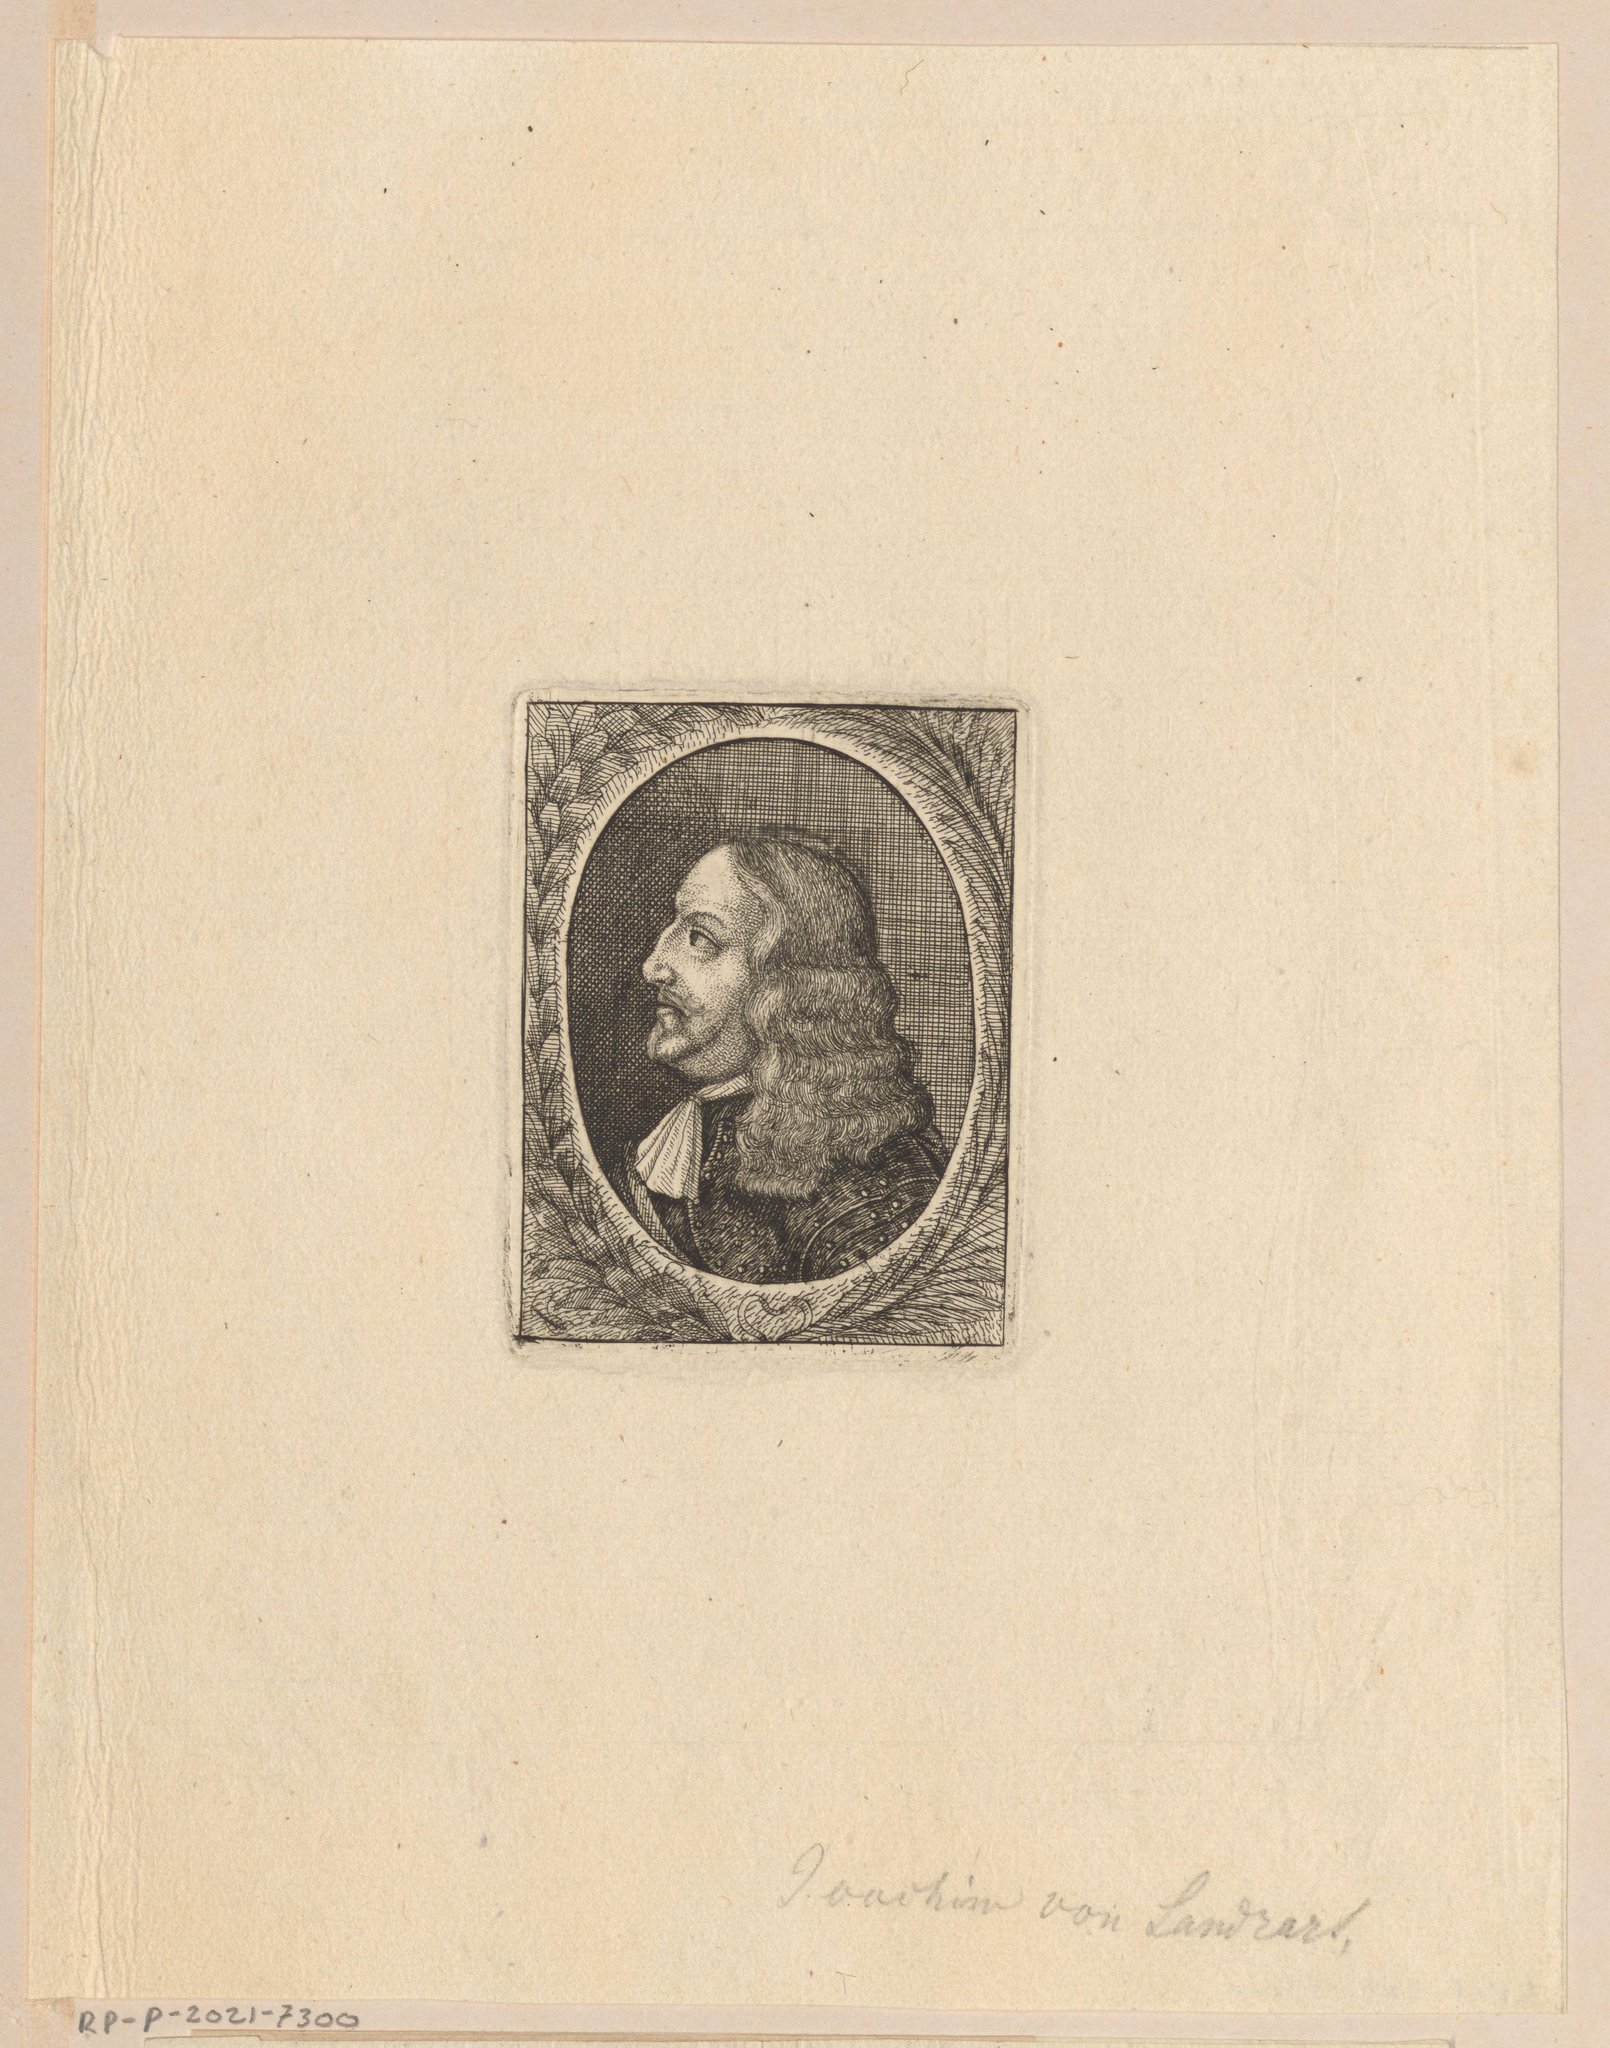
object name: print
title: Portret van een onbekende man, mogelijk Joachim von Sandrart I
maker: Anonymous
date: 1650-1749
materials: paper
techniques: etching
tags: historical persons, portrait, self-portrait of artist